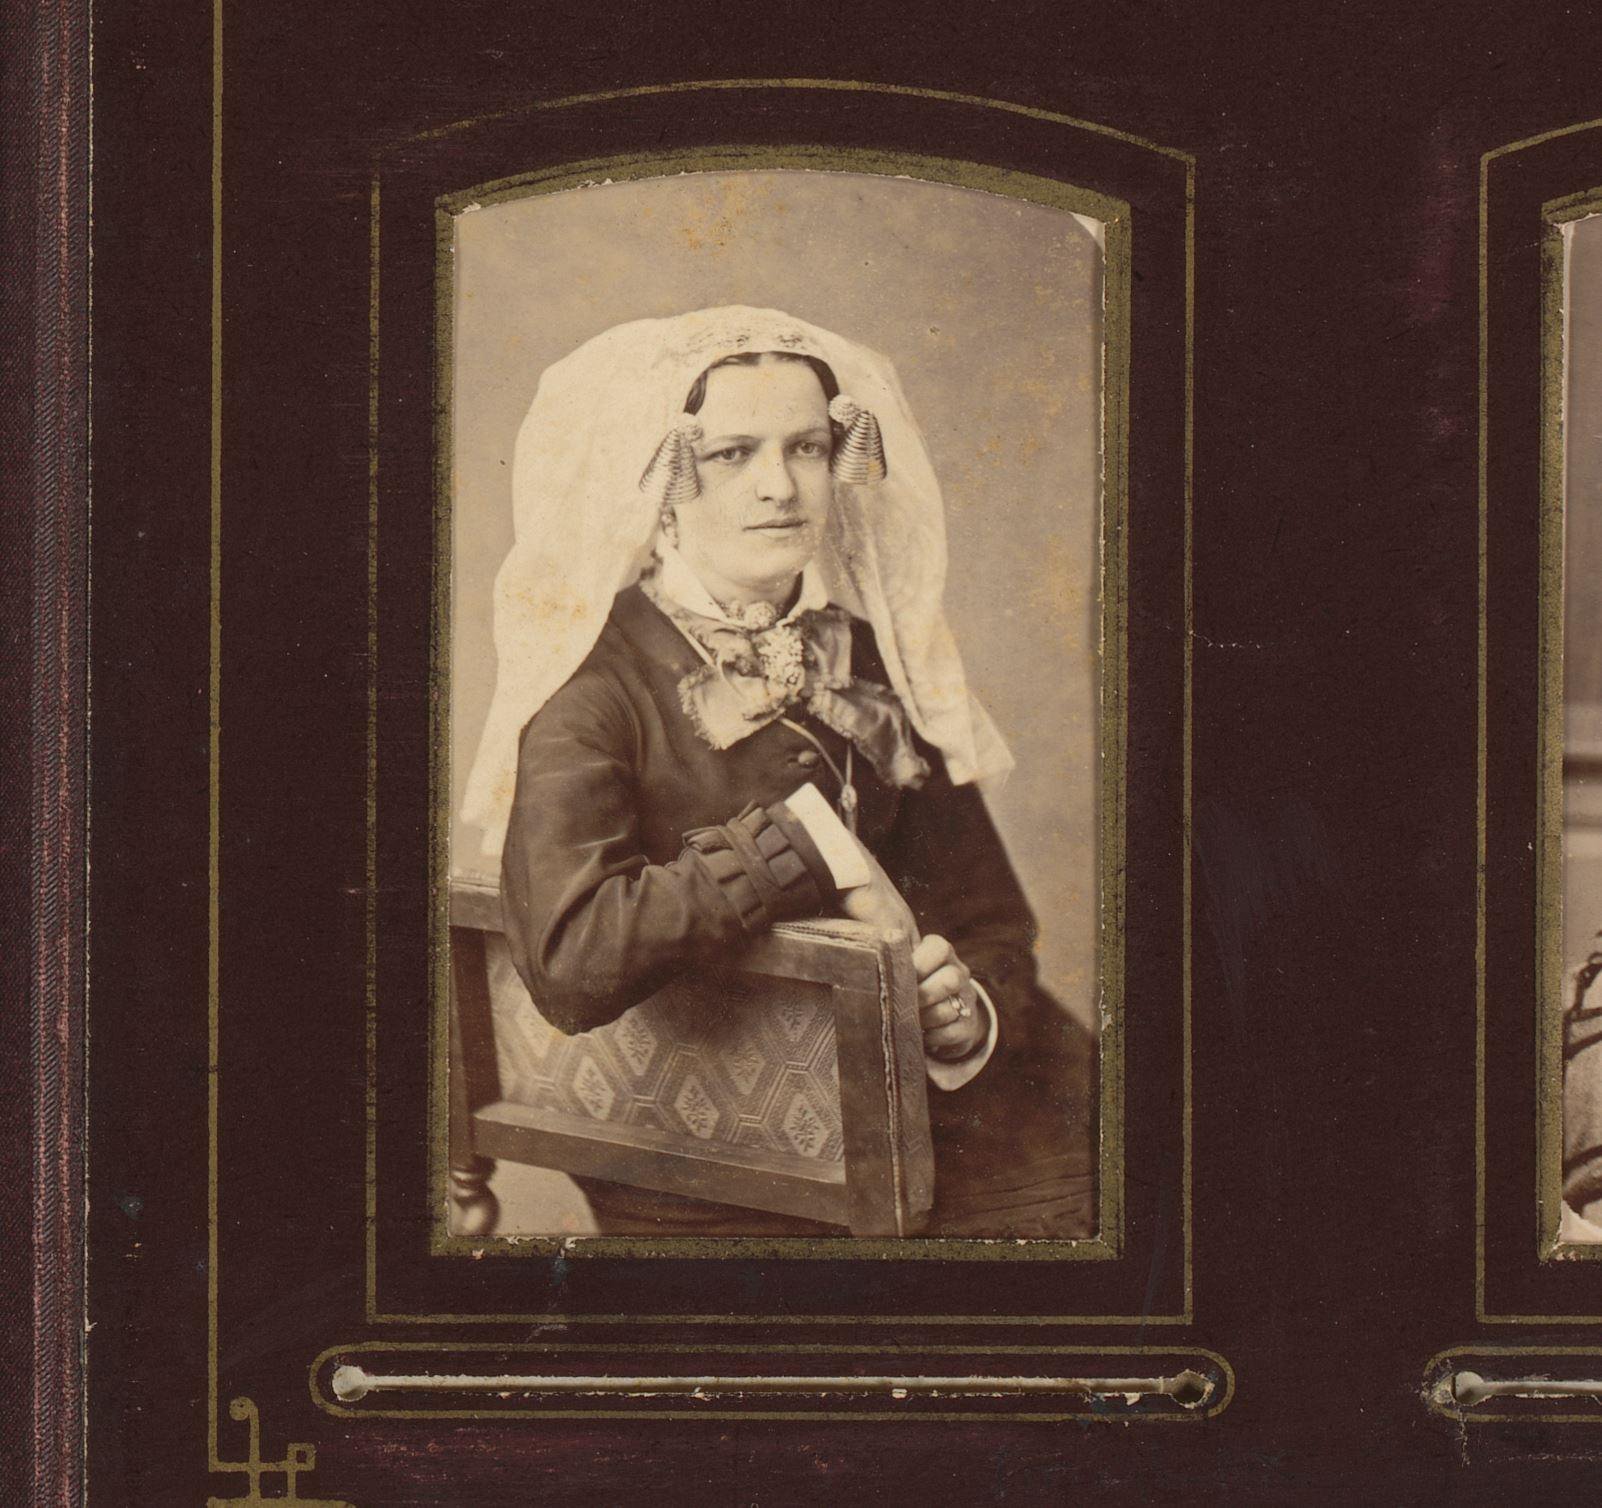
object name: carte de visite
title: Portret van een zittende vrouw met muts met oorijzers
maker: a. böeseken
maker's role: fotograaf, lithograaf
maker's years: 1834-1919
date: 1858-1890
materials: cardboard, photographic support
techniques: albumen print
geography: rotterdam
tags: historical persons - bb - woman, folk costume, regional costume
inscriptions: inscription: ‘A. Böeseken/ Photographisch Atelier/ Hoogstraat over de/ Vlasmarkt/ ROTTERDAM.’